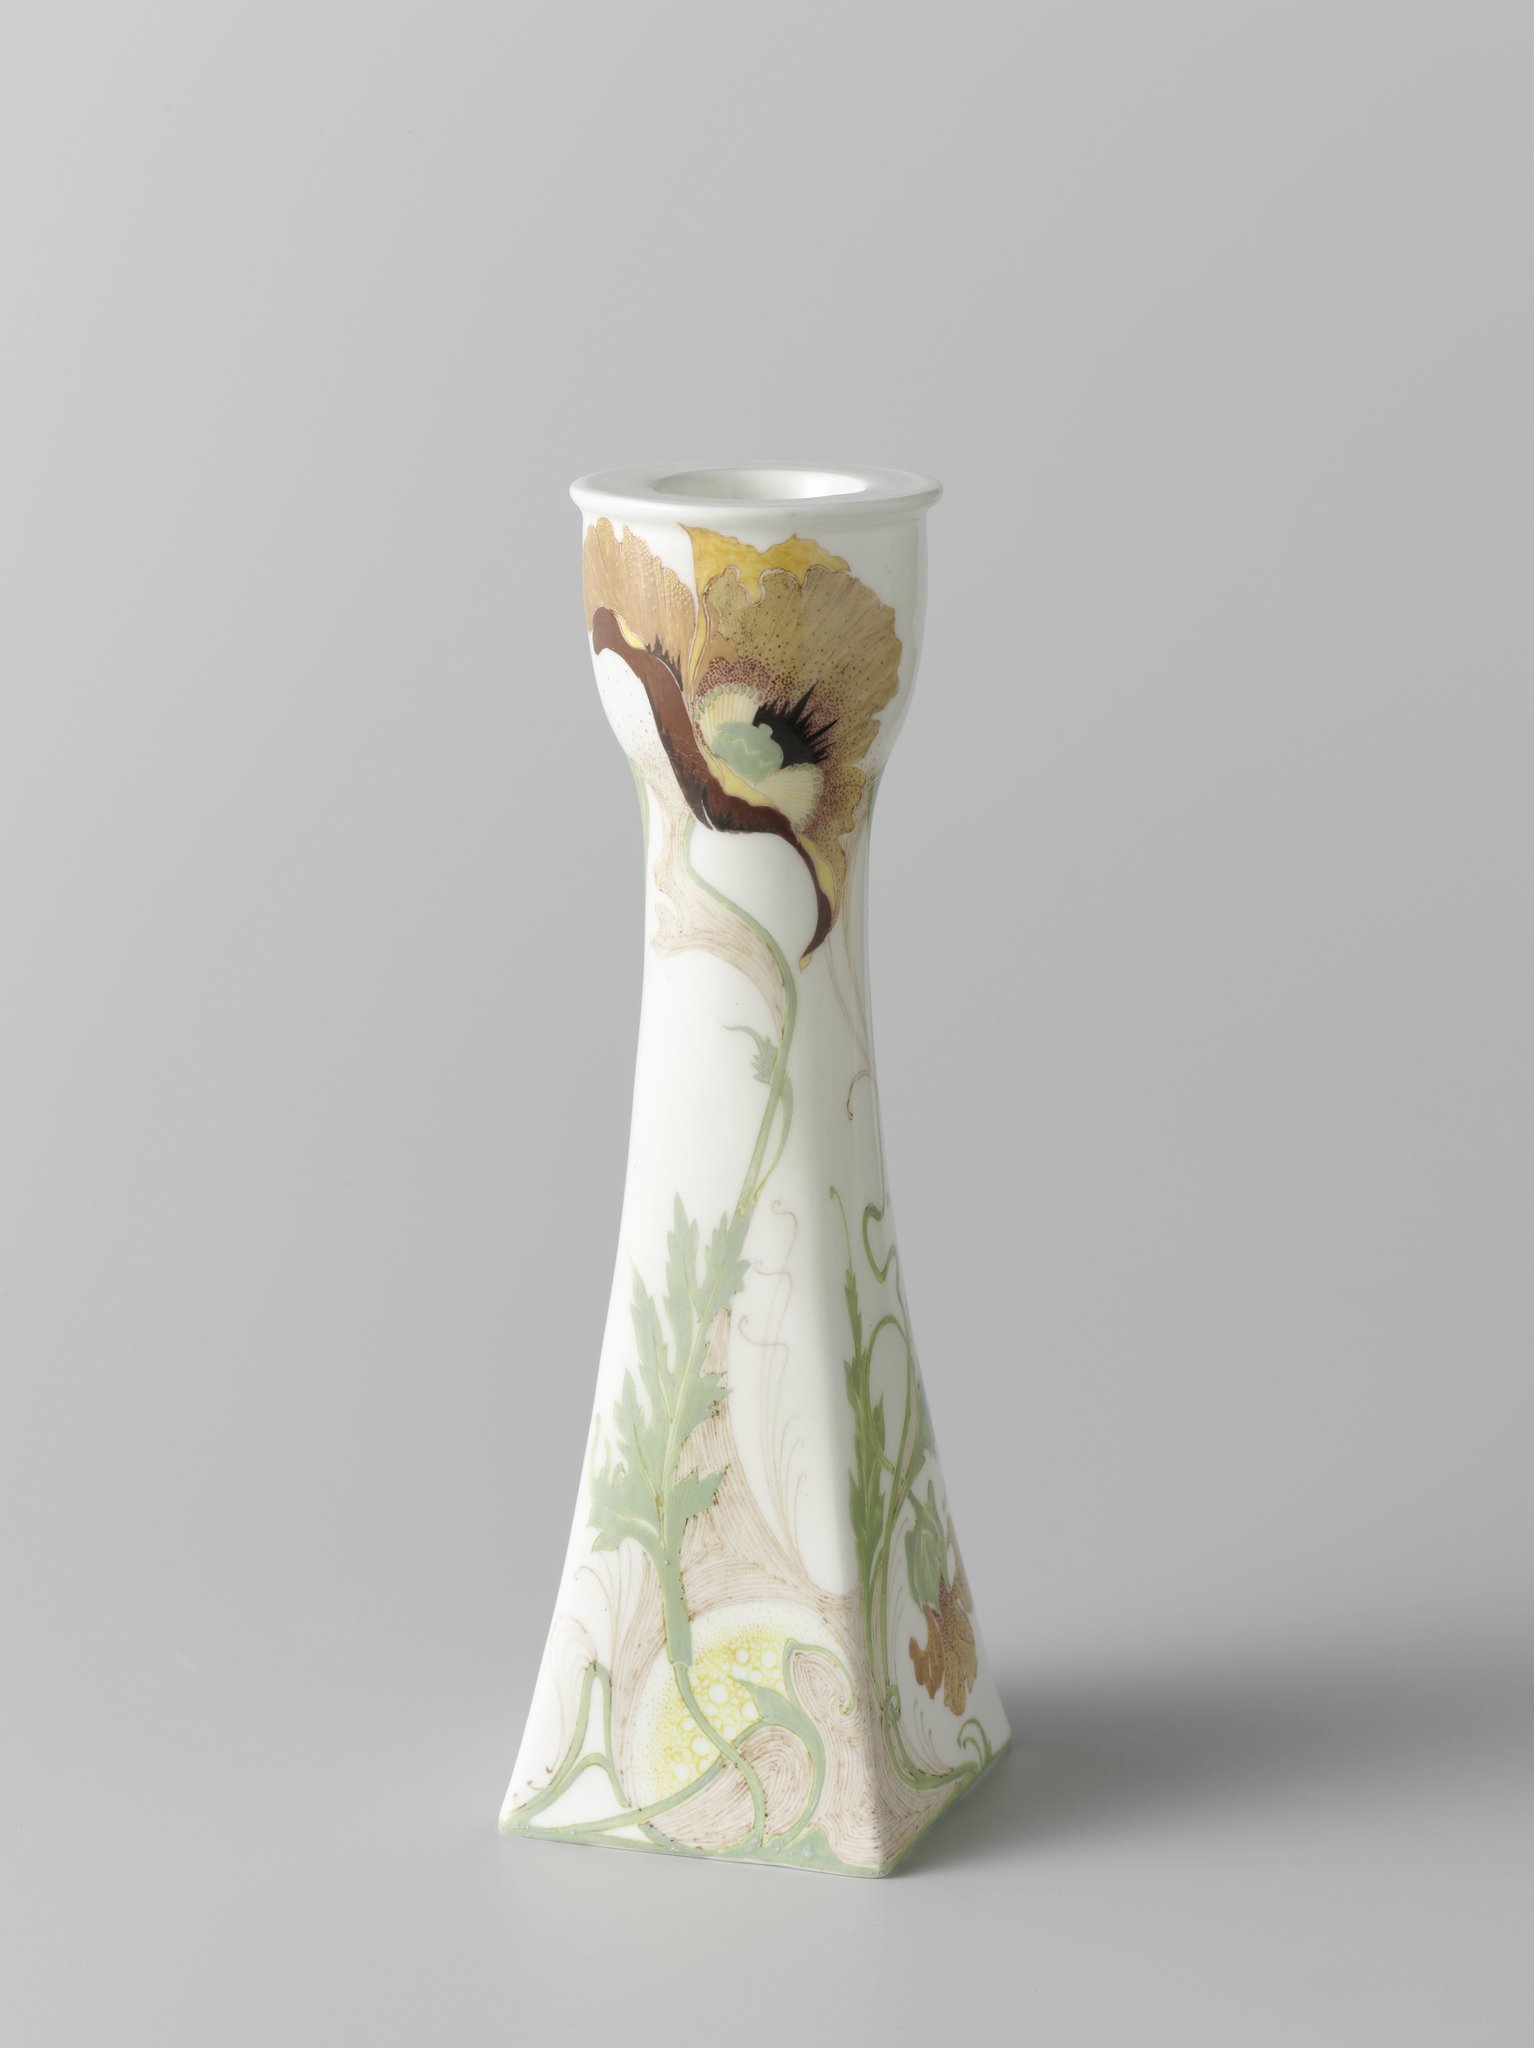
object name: candlestick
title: kandelaar van porselein beschilderd met bloemen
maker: sam schellink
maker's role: ceramicist, draughtsman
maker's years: 1876-1958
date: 1903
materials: porcelain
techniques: firing, painted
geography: the hague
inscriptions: mark: ‘alles in zwart: Rozenburg met kroon/ooievaar/Den Haag; links ster (=1903); rechts werkordernummer 448 en schildersmerk S met schuine streep in zwart; modelnummer 212 in reliëf’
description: Candlestick. 1903, decorated by Samuel Schellink, model no 212.